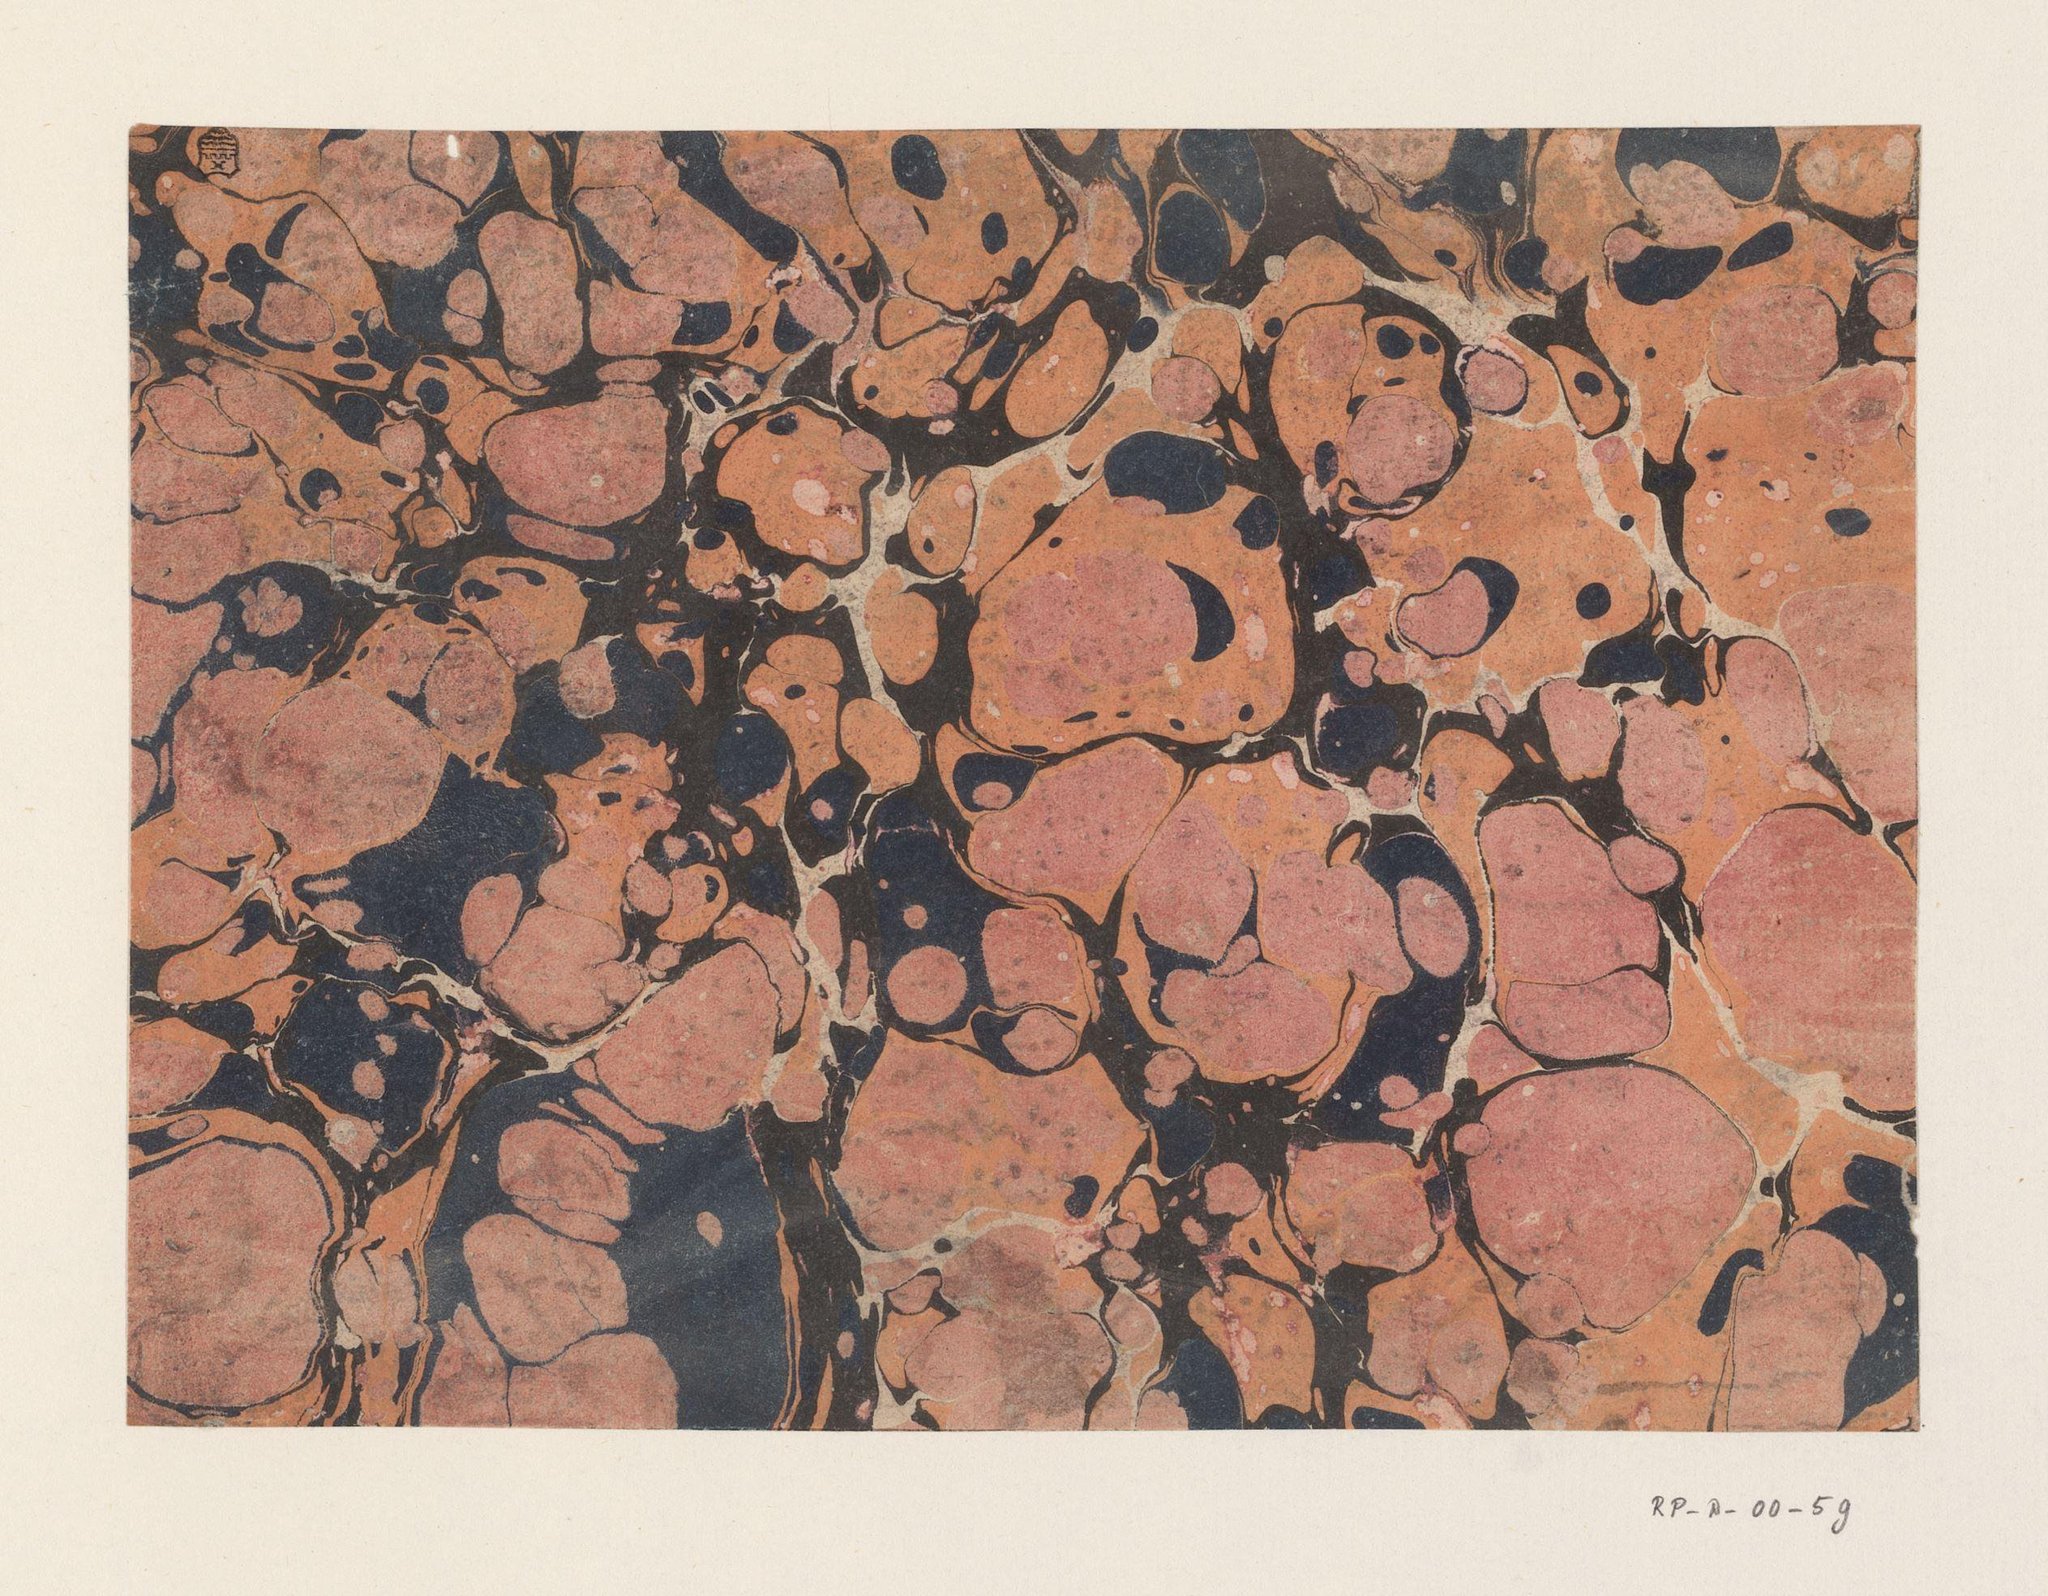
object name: marbled paper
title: Kiezelmarmer in oranje, zwart, blauw en roze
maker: Anonymous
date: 1700-1850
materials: paint, paper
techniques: marbling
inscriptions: collector's mark: Lugt 2760